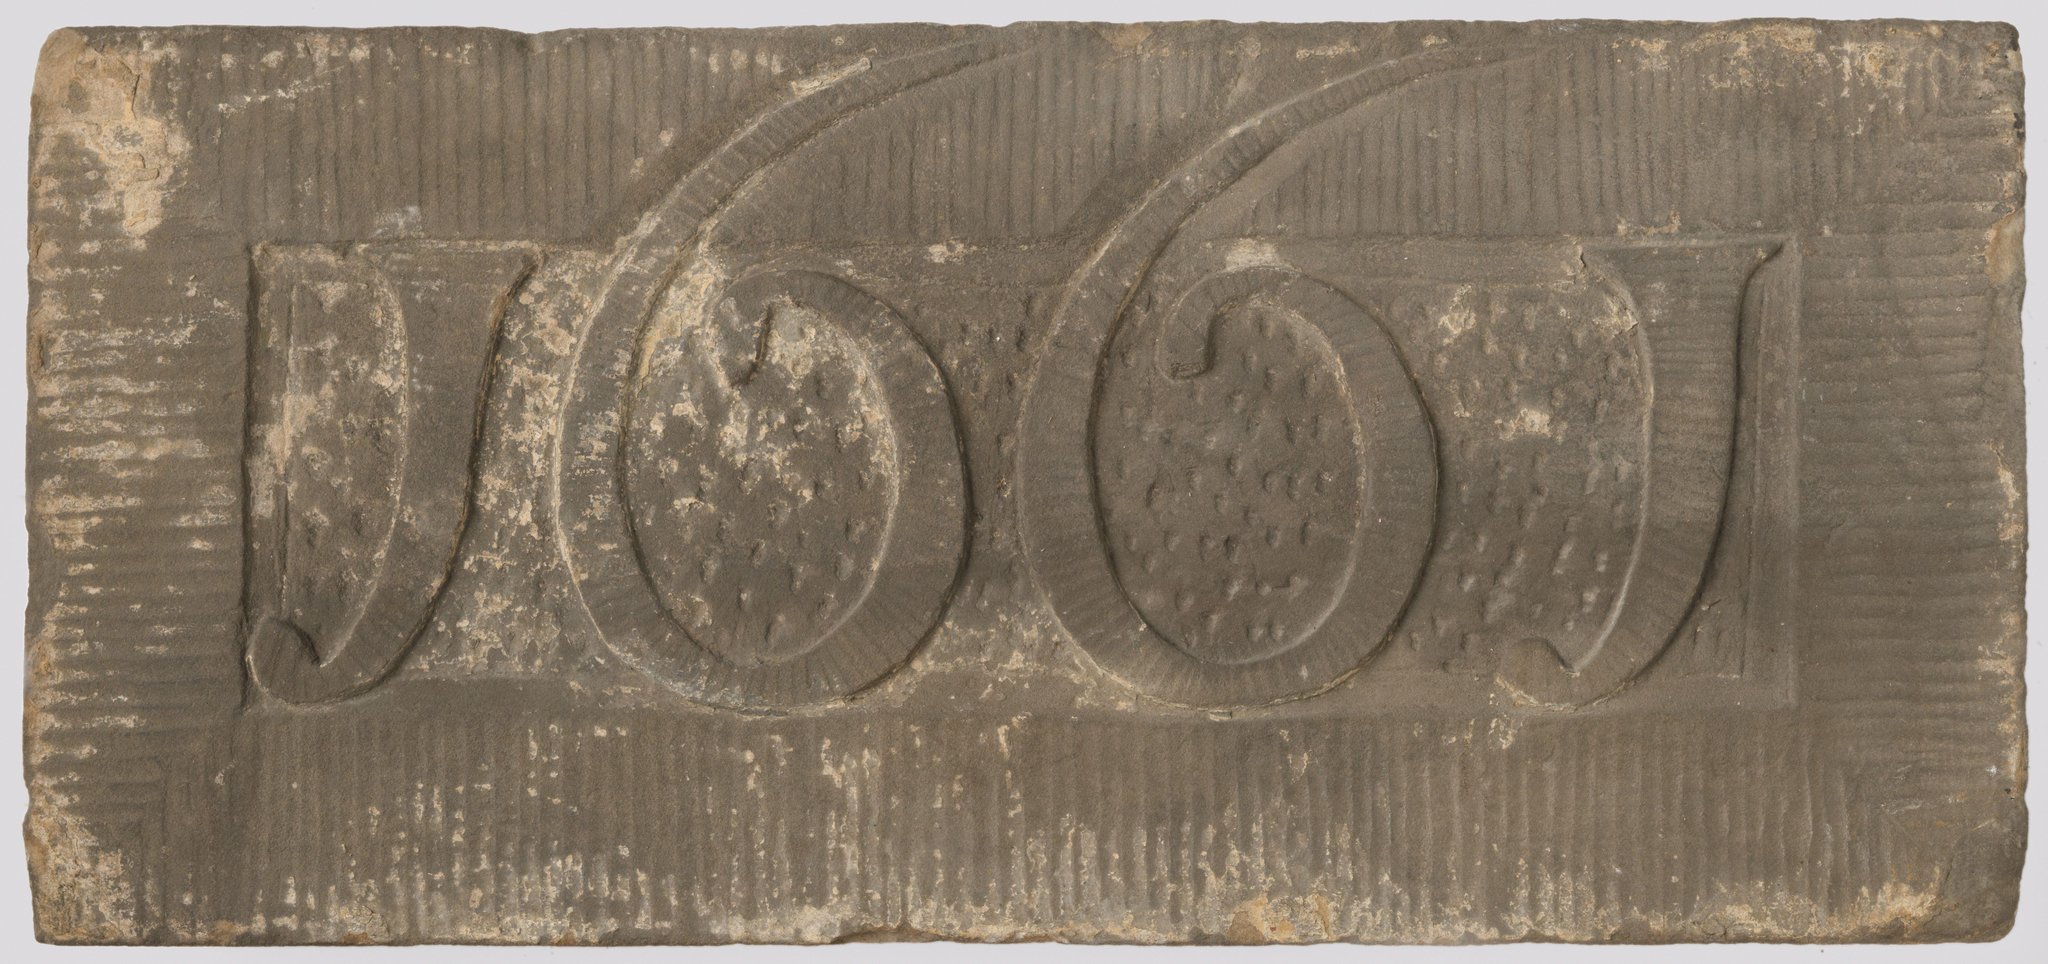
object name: gable stone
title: Gevelsteen met jaartal 1661.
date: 1661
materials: stone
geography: netherlands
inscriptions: date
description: Liggende rechthoek met een brede gearceerde rand, waarbinnen het jaartal 1661. De gevelsteen hoort bij twee gevelstenen (KOG-ALS-144-1 met D LOOSMAN en KOG-ALS-144-2 met ANNO).